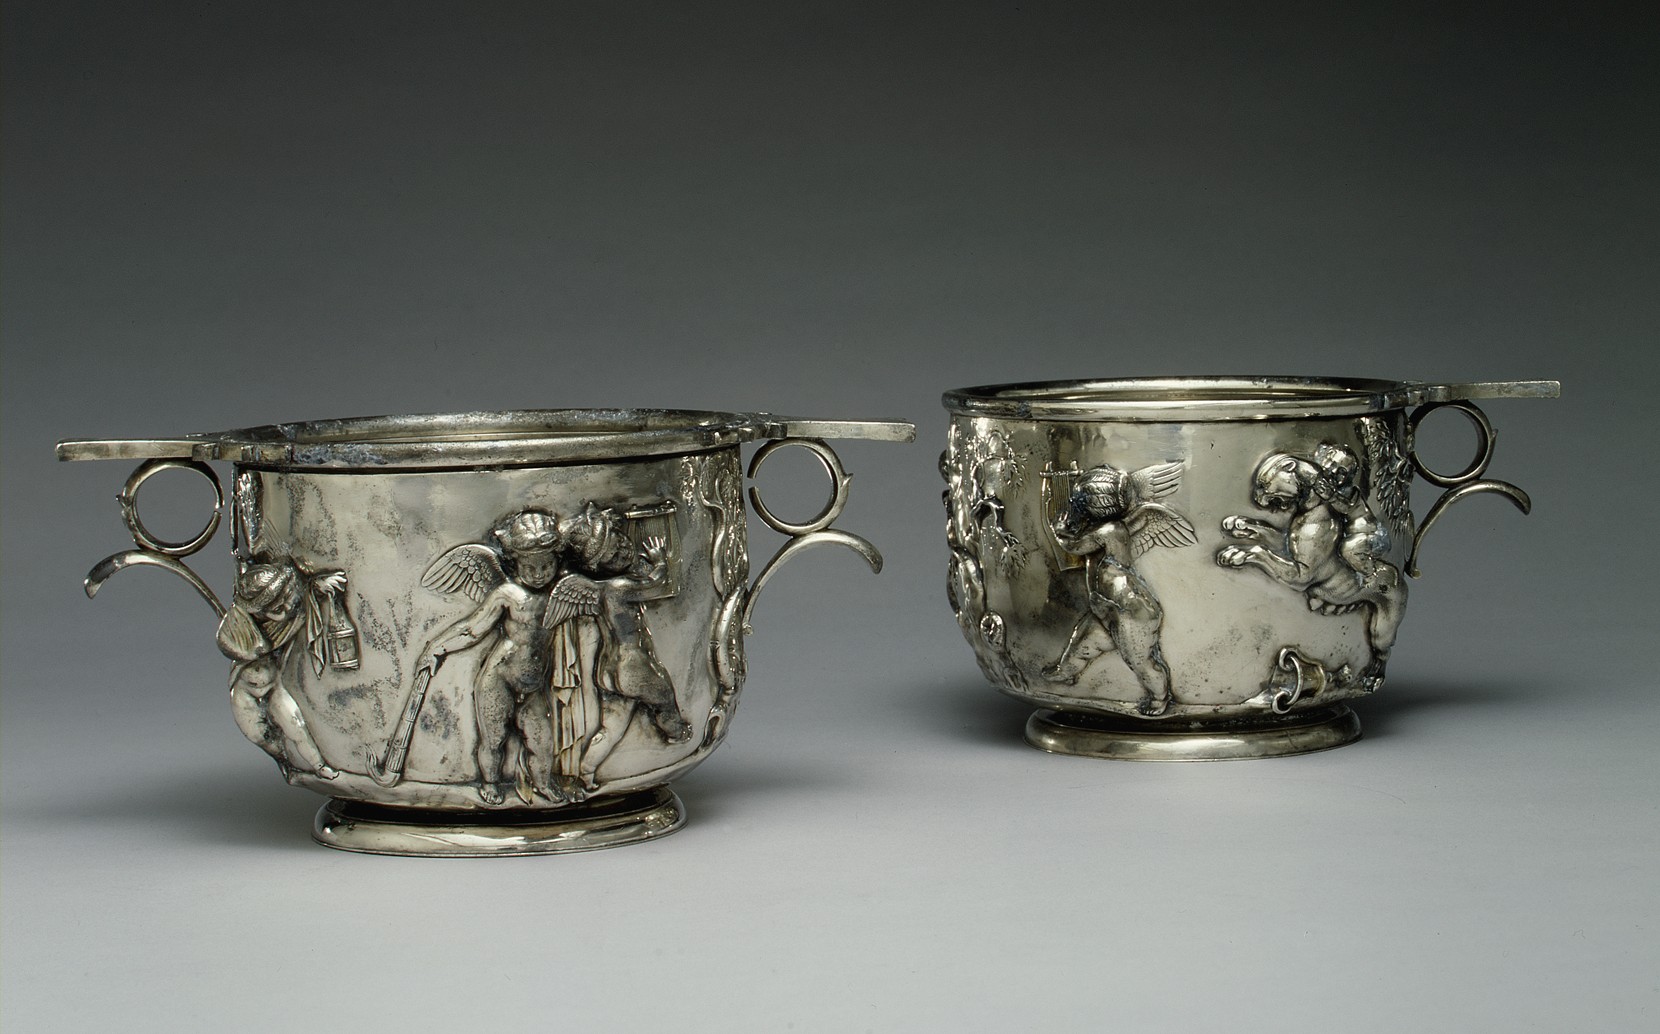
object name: skyphos with erotes, pair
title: Pair of silver scyphi (cups) with relief decoration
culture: roman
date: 34 BCE-33 CE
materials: silver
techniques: gilding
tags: musical instruments,animals,dancing,cupid